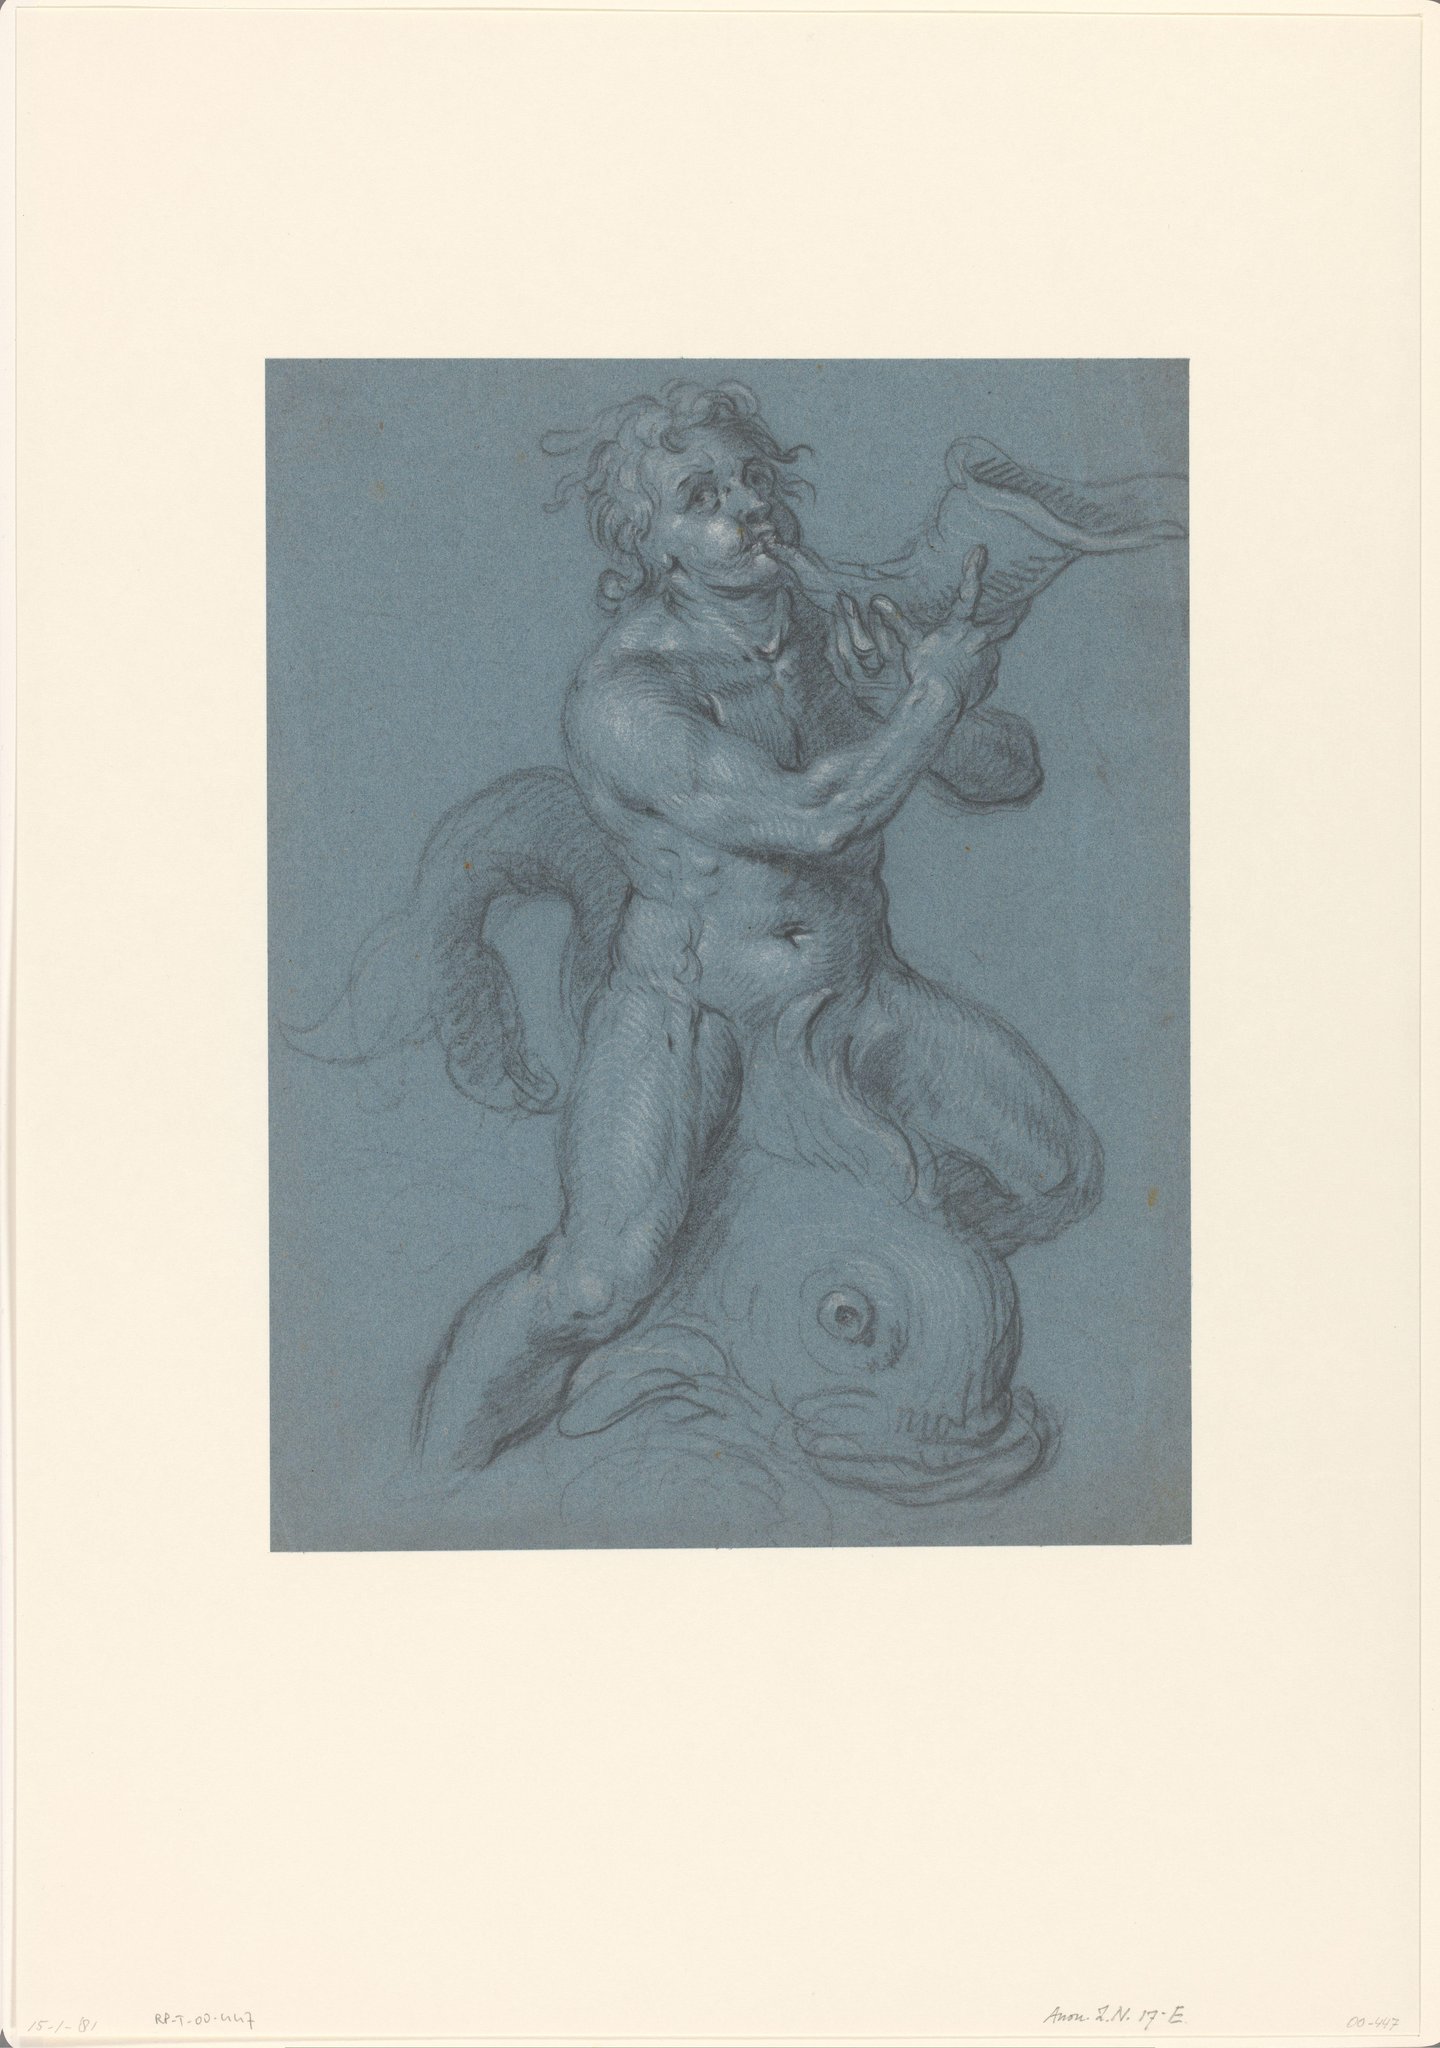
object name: drawing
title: Triton blaast op zijn hoorn zittend op een dolfijn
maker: Anonymous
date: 1600-1699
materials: chalk, paper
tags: triton blows on a twisted sea shell to raise or calm the waves